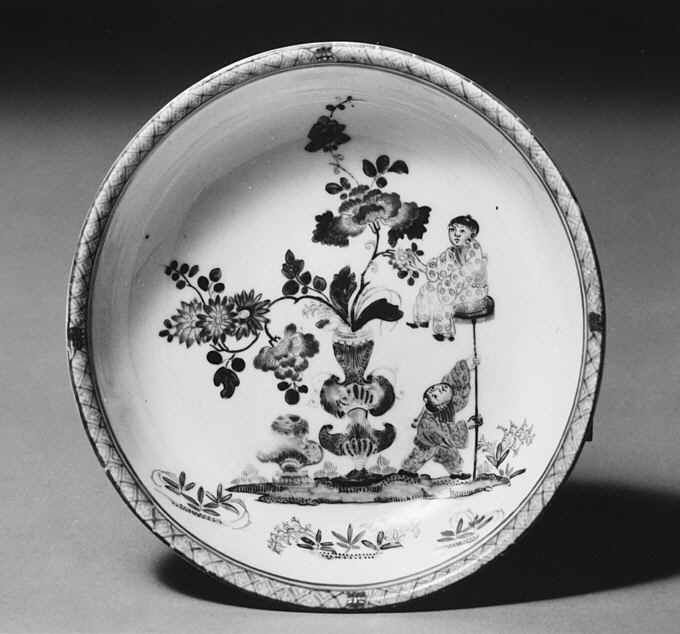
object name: saucer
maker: vienna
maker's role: manufactory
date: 1730-1735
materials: hard paste porcelain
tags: human figures,flowers